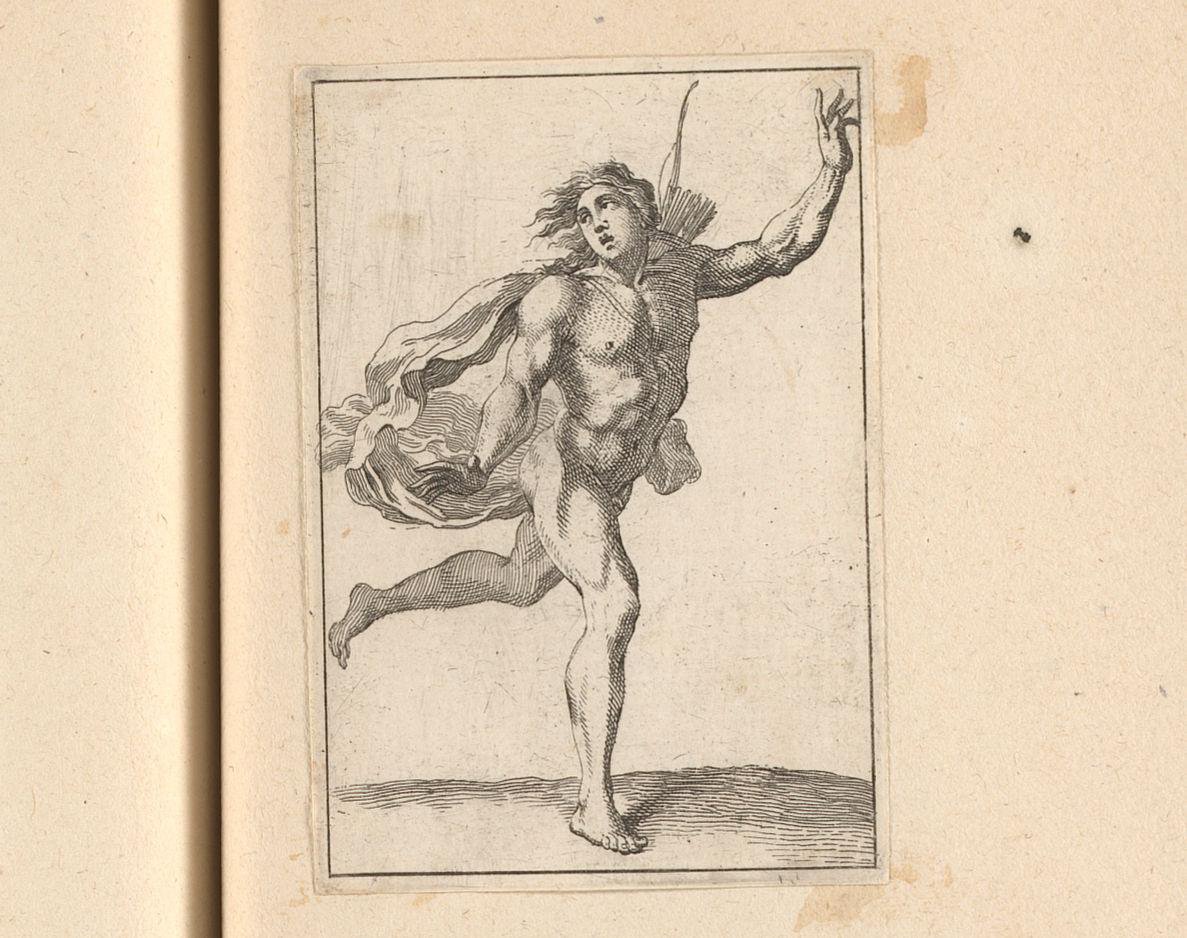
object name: print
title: Apollo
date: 1665-1673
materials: paper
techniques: etching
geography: paris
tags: model-books ~ implements of painter, (story of) apollo (phoebus)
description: Maakt deel uit van een 32-delige serie met tekenvoorbeelden van goden en helden uit de klassieke oudheid. Een eerste editie werd in 1673 uitgegeven en een tweede in 1684 door Nicolas Langlois.